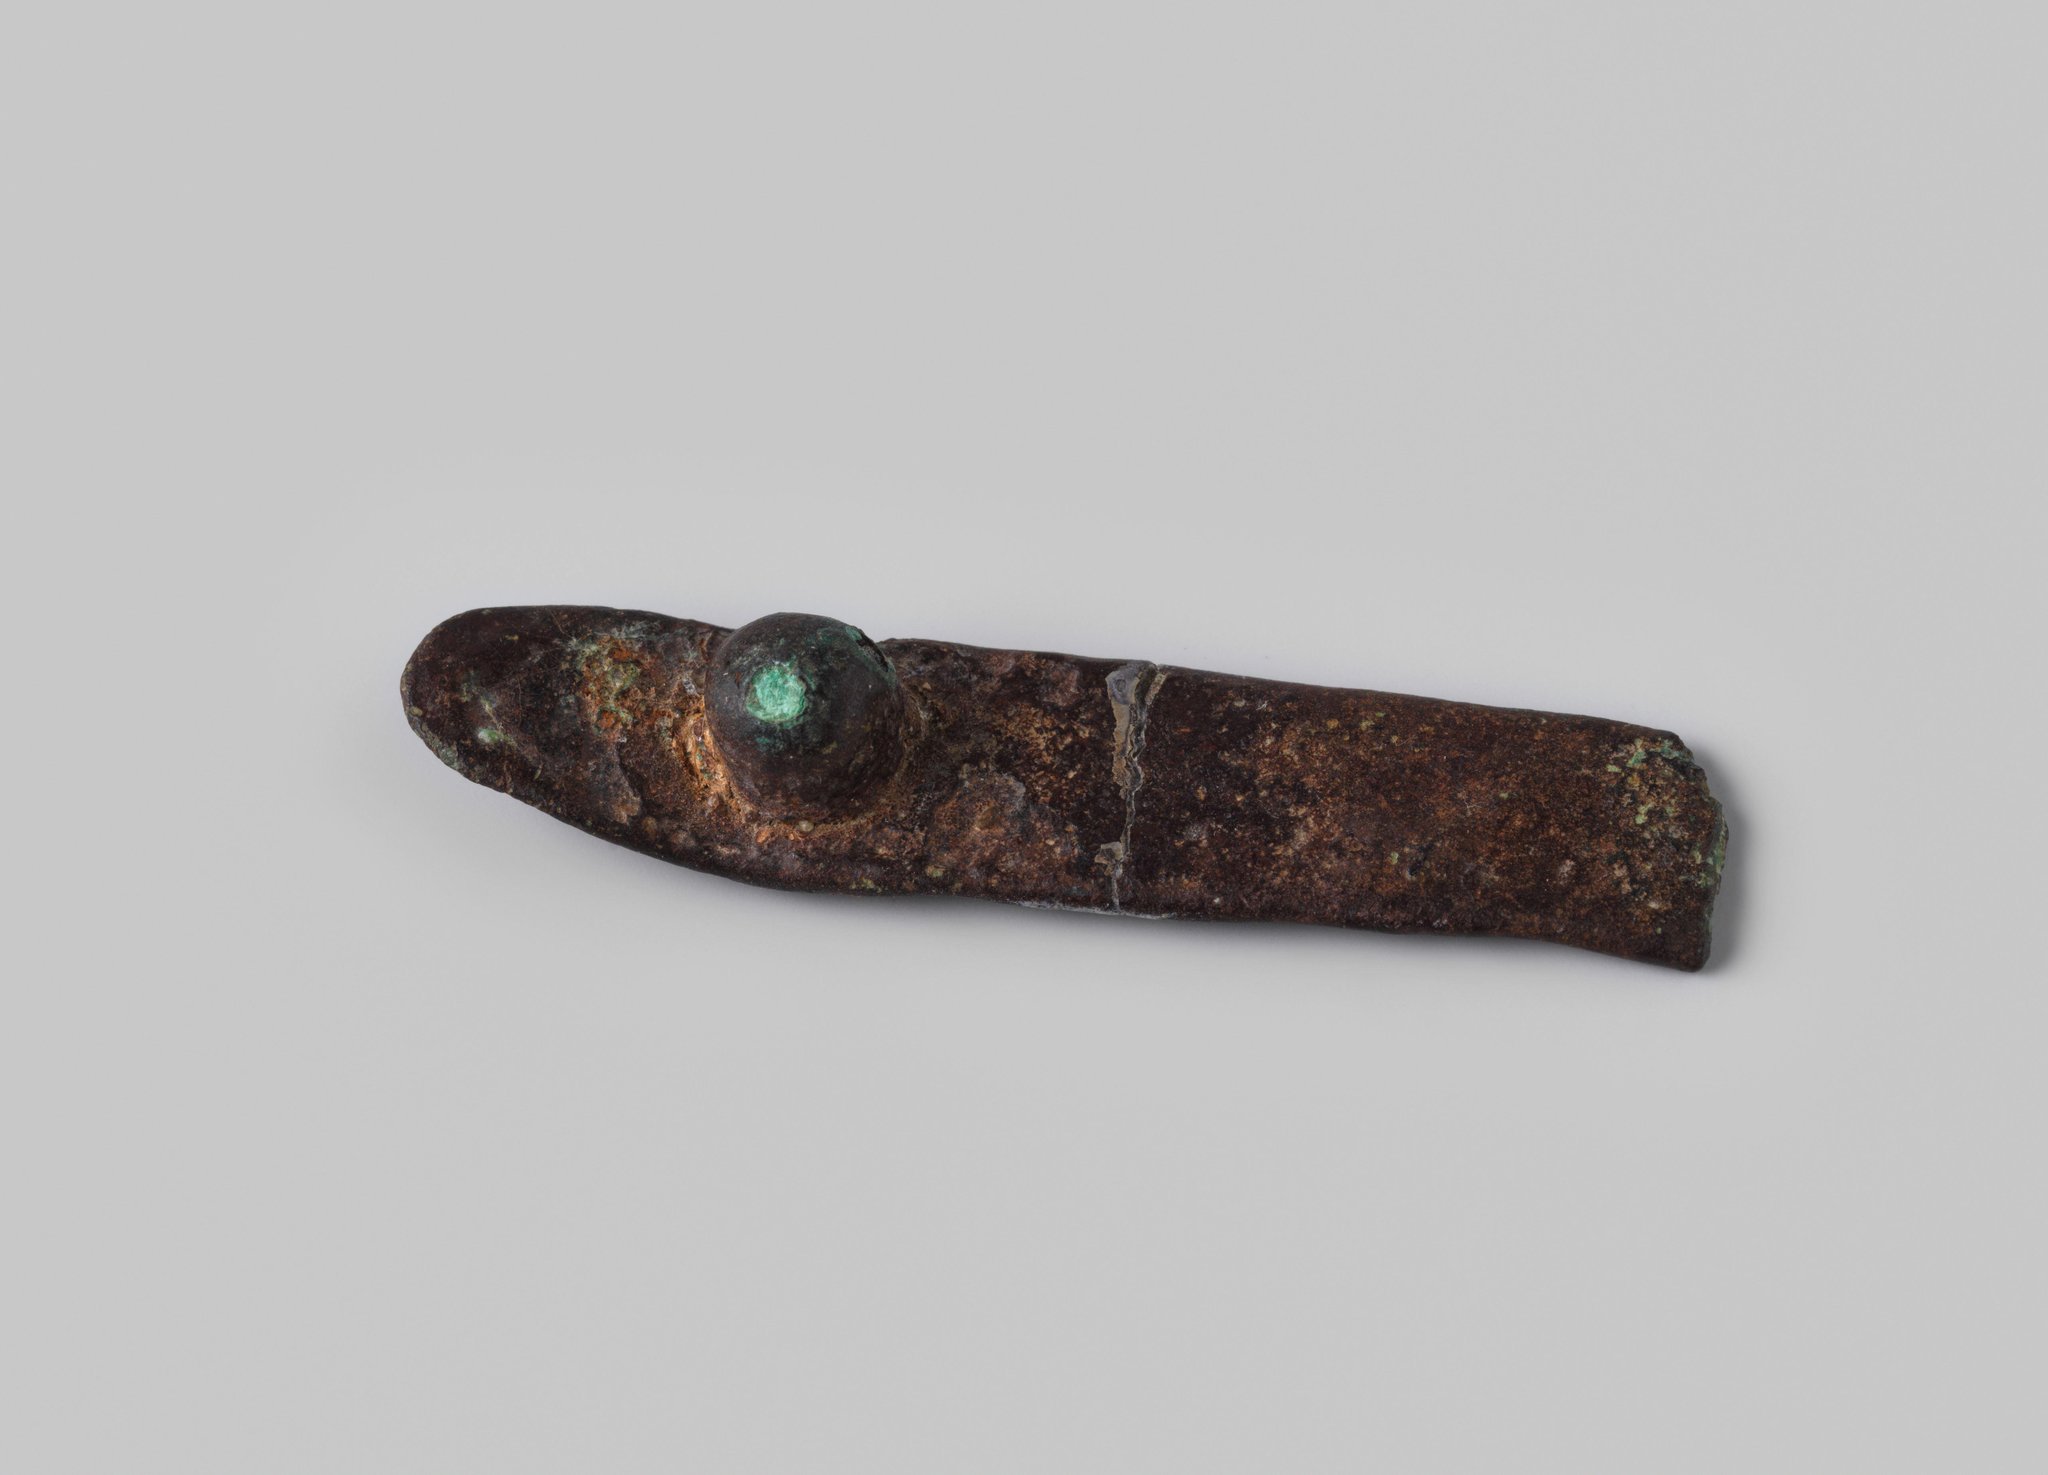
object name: fragment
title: Fragment van koper uit het wrak van de Oost-Indiëvaarder Hollandia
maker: Anonymous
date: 1700-1743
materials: copper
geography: netherlands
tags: verenigde oostindische compagnie, hollandia (schip), annet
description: Varied parts or fragments, strips and strip-shaped fragments; fragm.